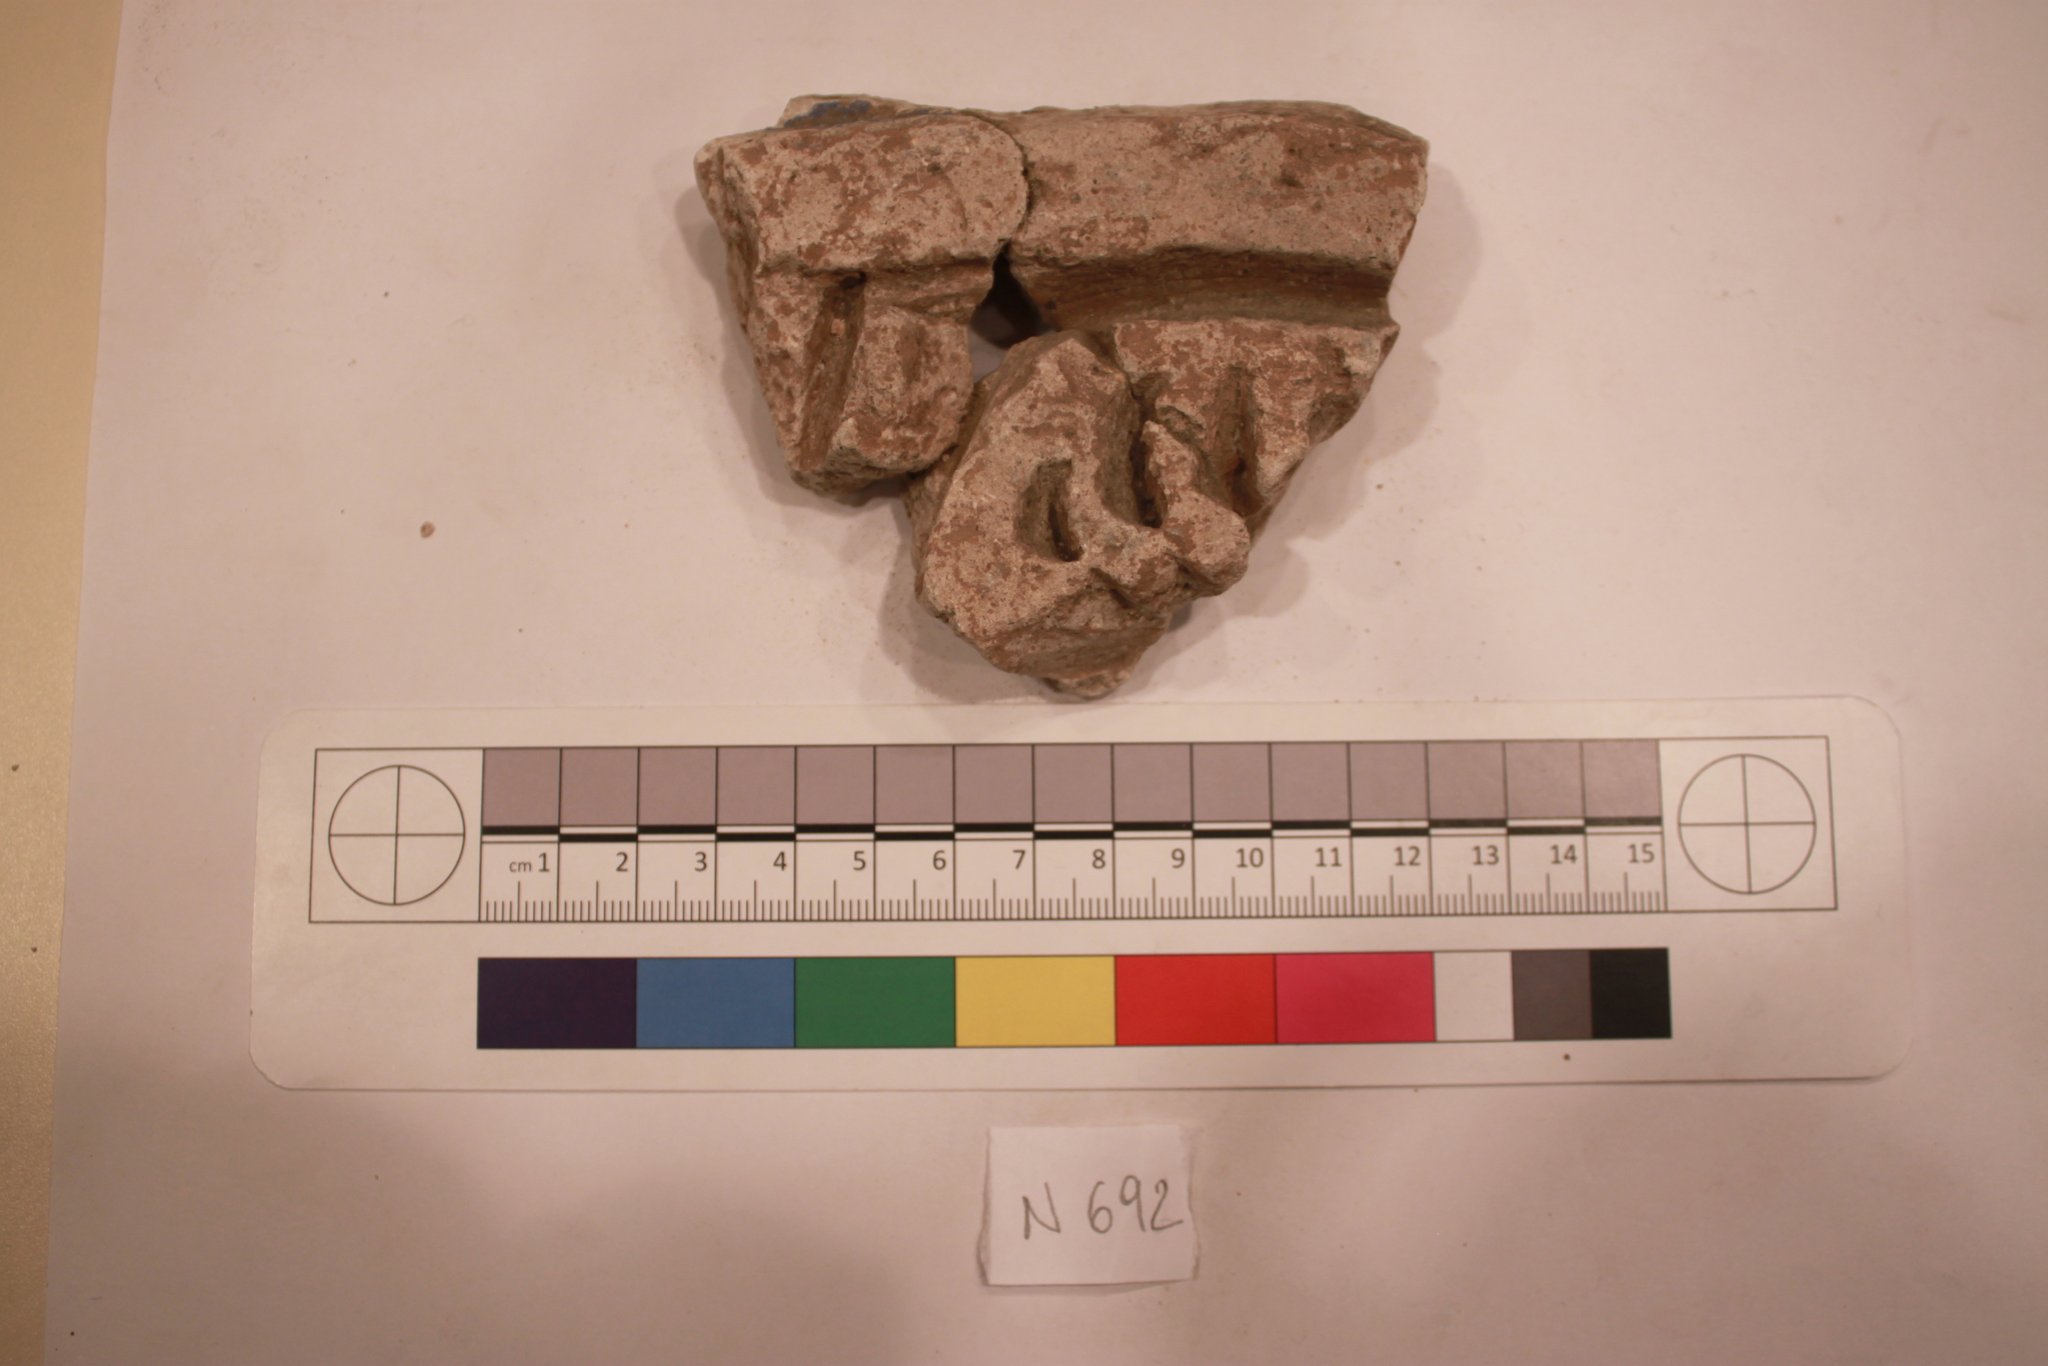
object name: fragment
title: Stucco Fragment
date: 701-1200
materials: plaster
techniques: carving, painting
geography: iran